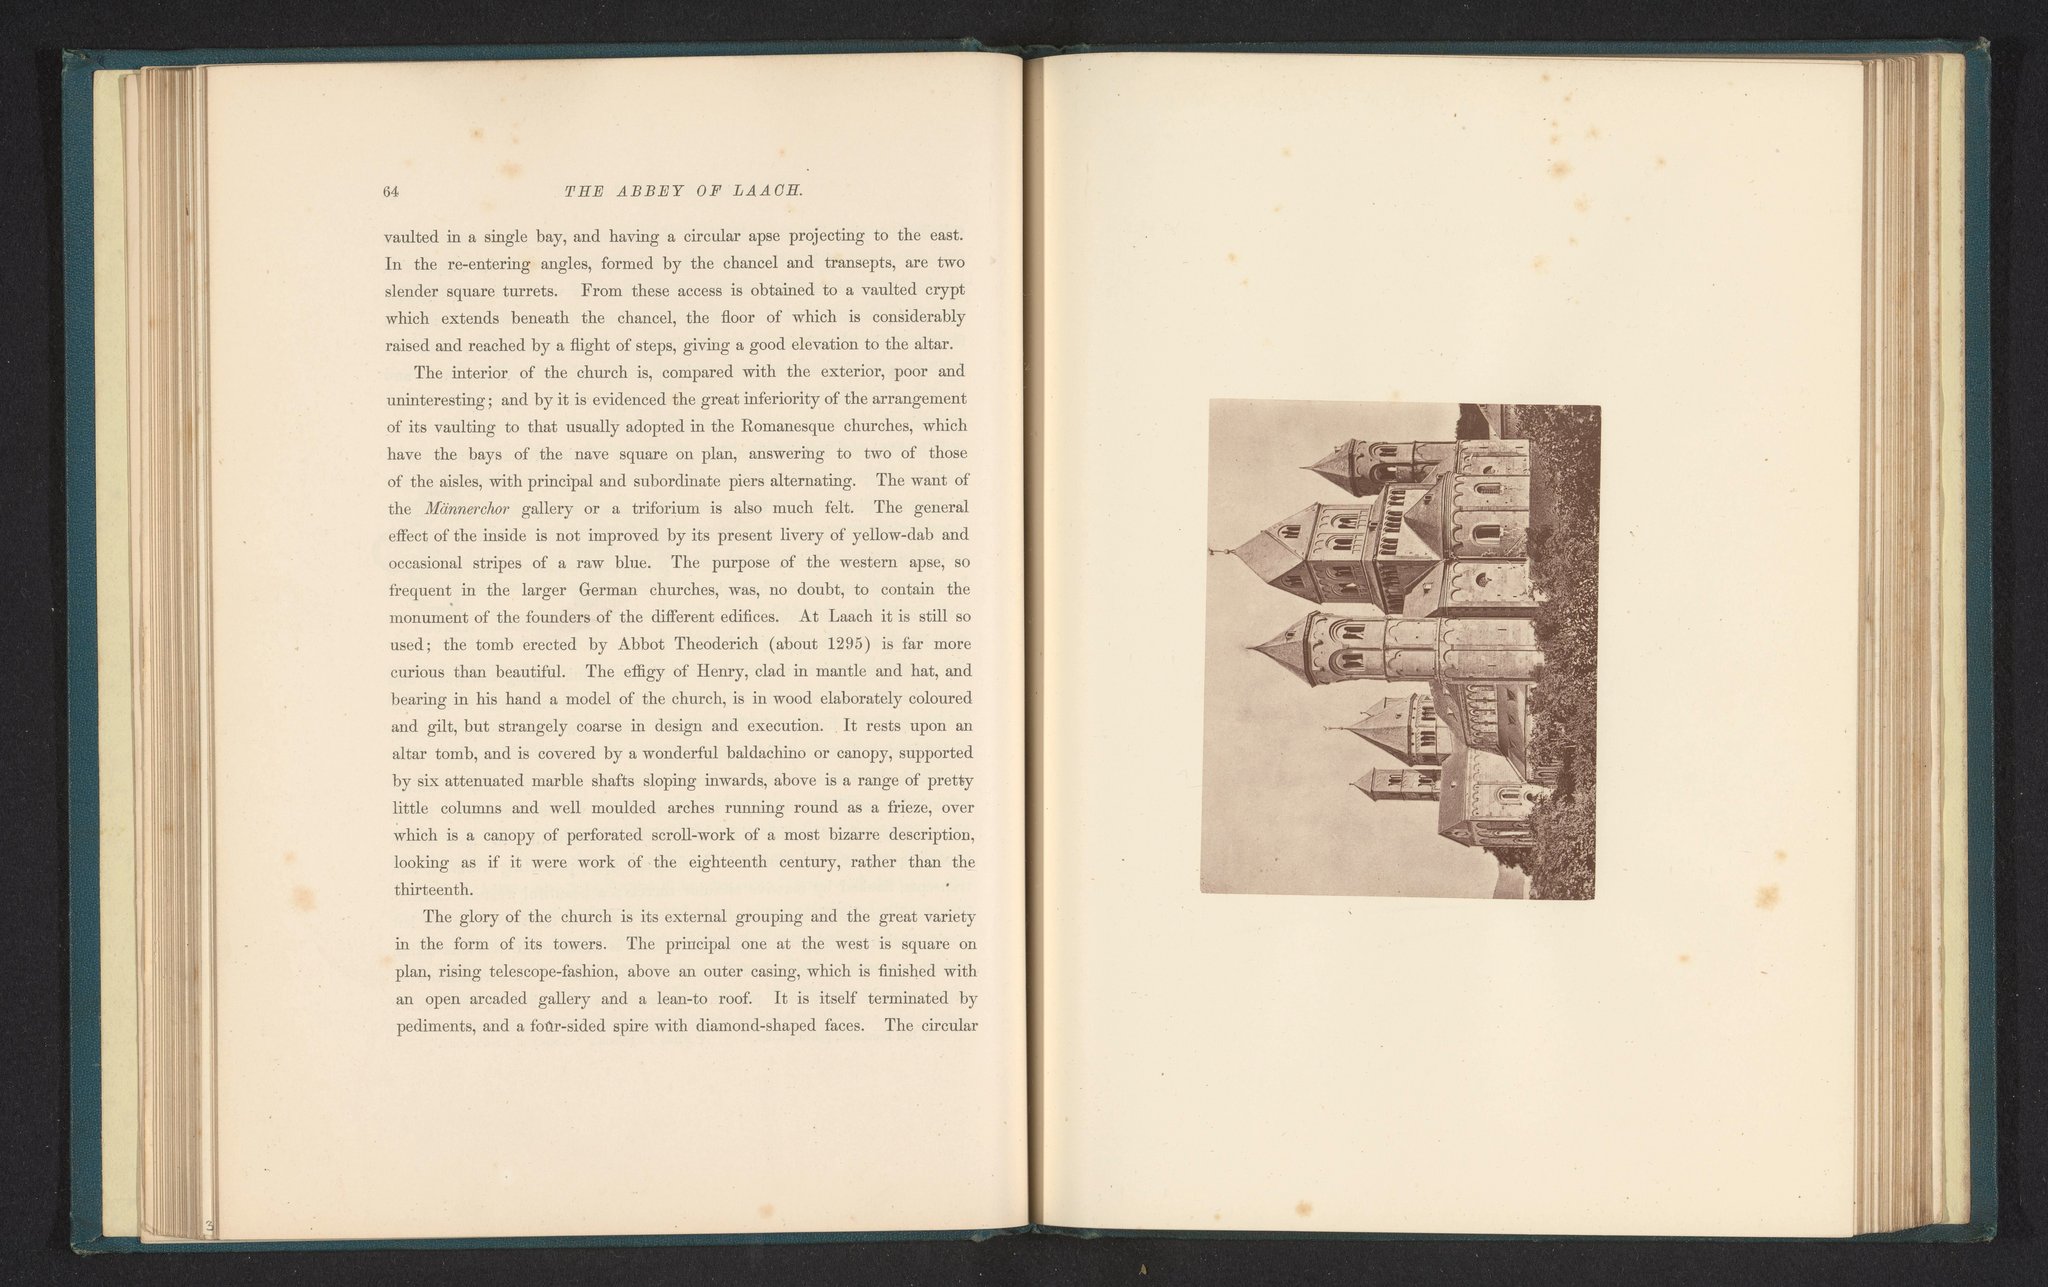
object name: page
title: Fotoreproductie van een gezicht op de Abdij van Maria Laach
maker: Anonymous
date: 1858-1868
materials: paper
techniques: woodburytype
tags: abbey, monastery, convent ~ roman catholic church